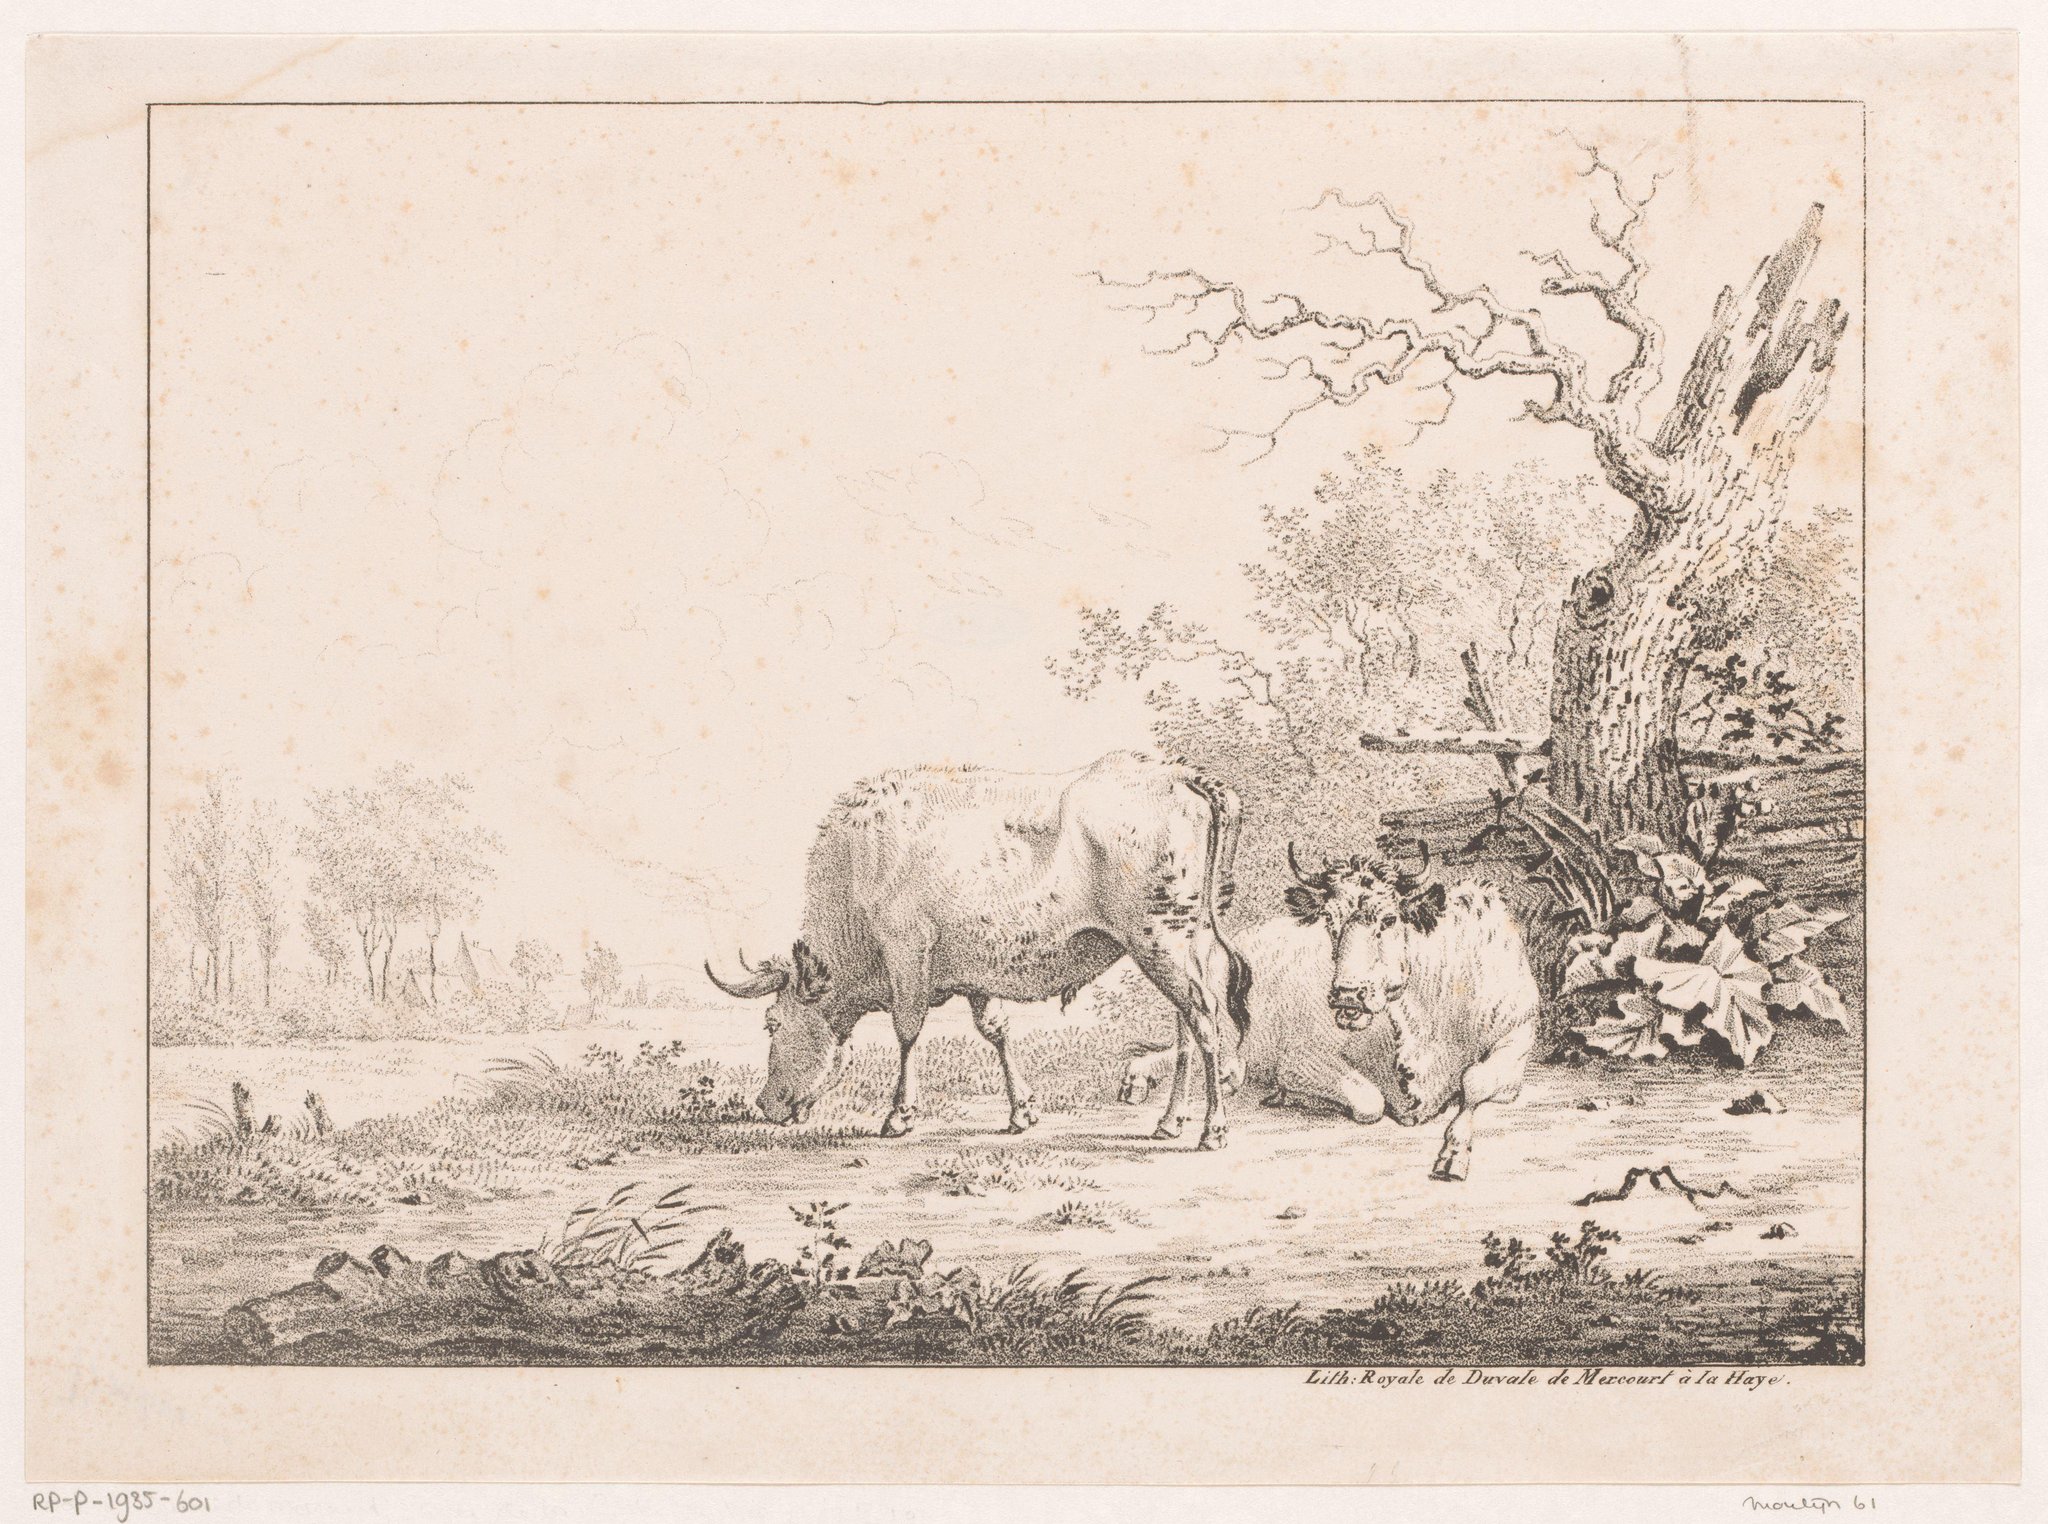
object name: print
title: Twee koeien in een landschap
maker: m. j. v. duval de mercourt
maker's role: print maker, printer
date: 1818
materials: paper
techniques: lithograph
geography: the hague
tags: cow, landscapes in the temperate zone (+ landscape with figures, staffage)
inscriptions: collector's mark: Lugt 2760, collector's mark: Lugt 2228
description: Illustratie uit: Duval de Mercourt, 1818. Volgens Moulijn is de prentmaker Jan Kobell (1755-1833). Hij vermeldt namelijk diens dochter Anna Kobell (1790-1847). Volgens Marres-Schretlen gaat het om Jan Kobell (1800-1838), bijgenaamd 'de Rotterdamse Kobell'.